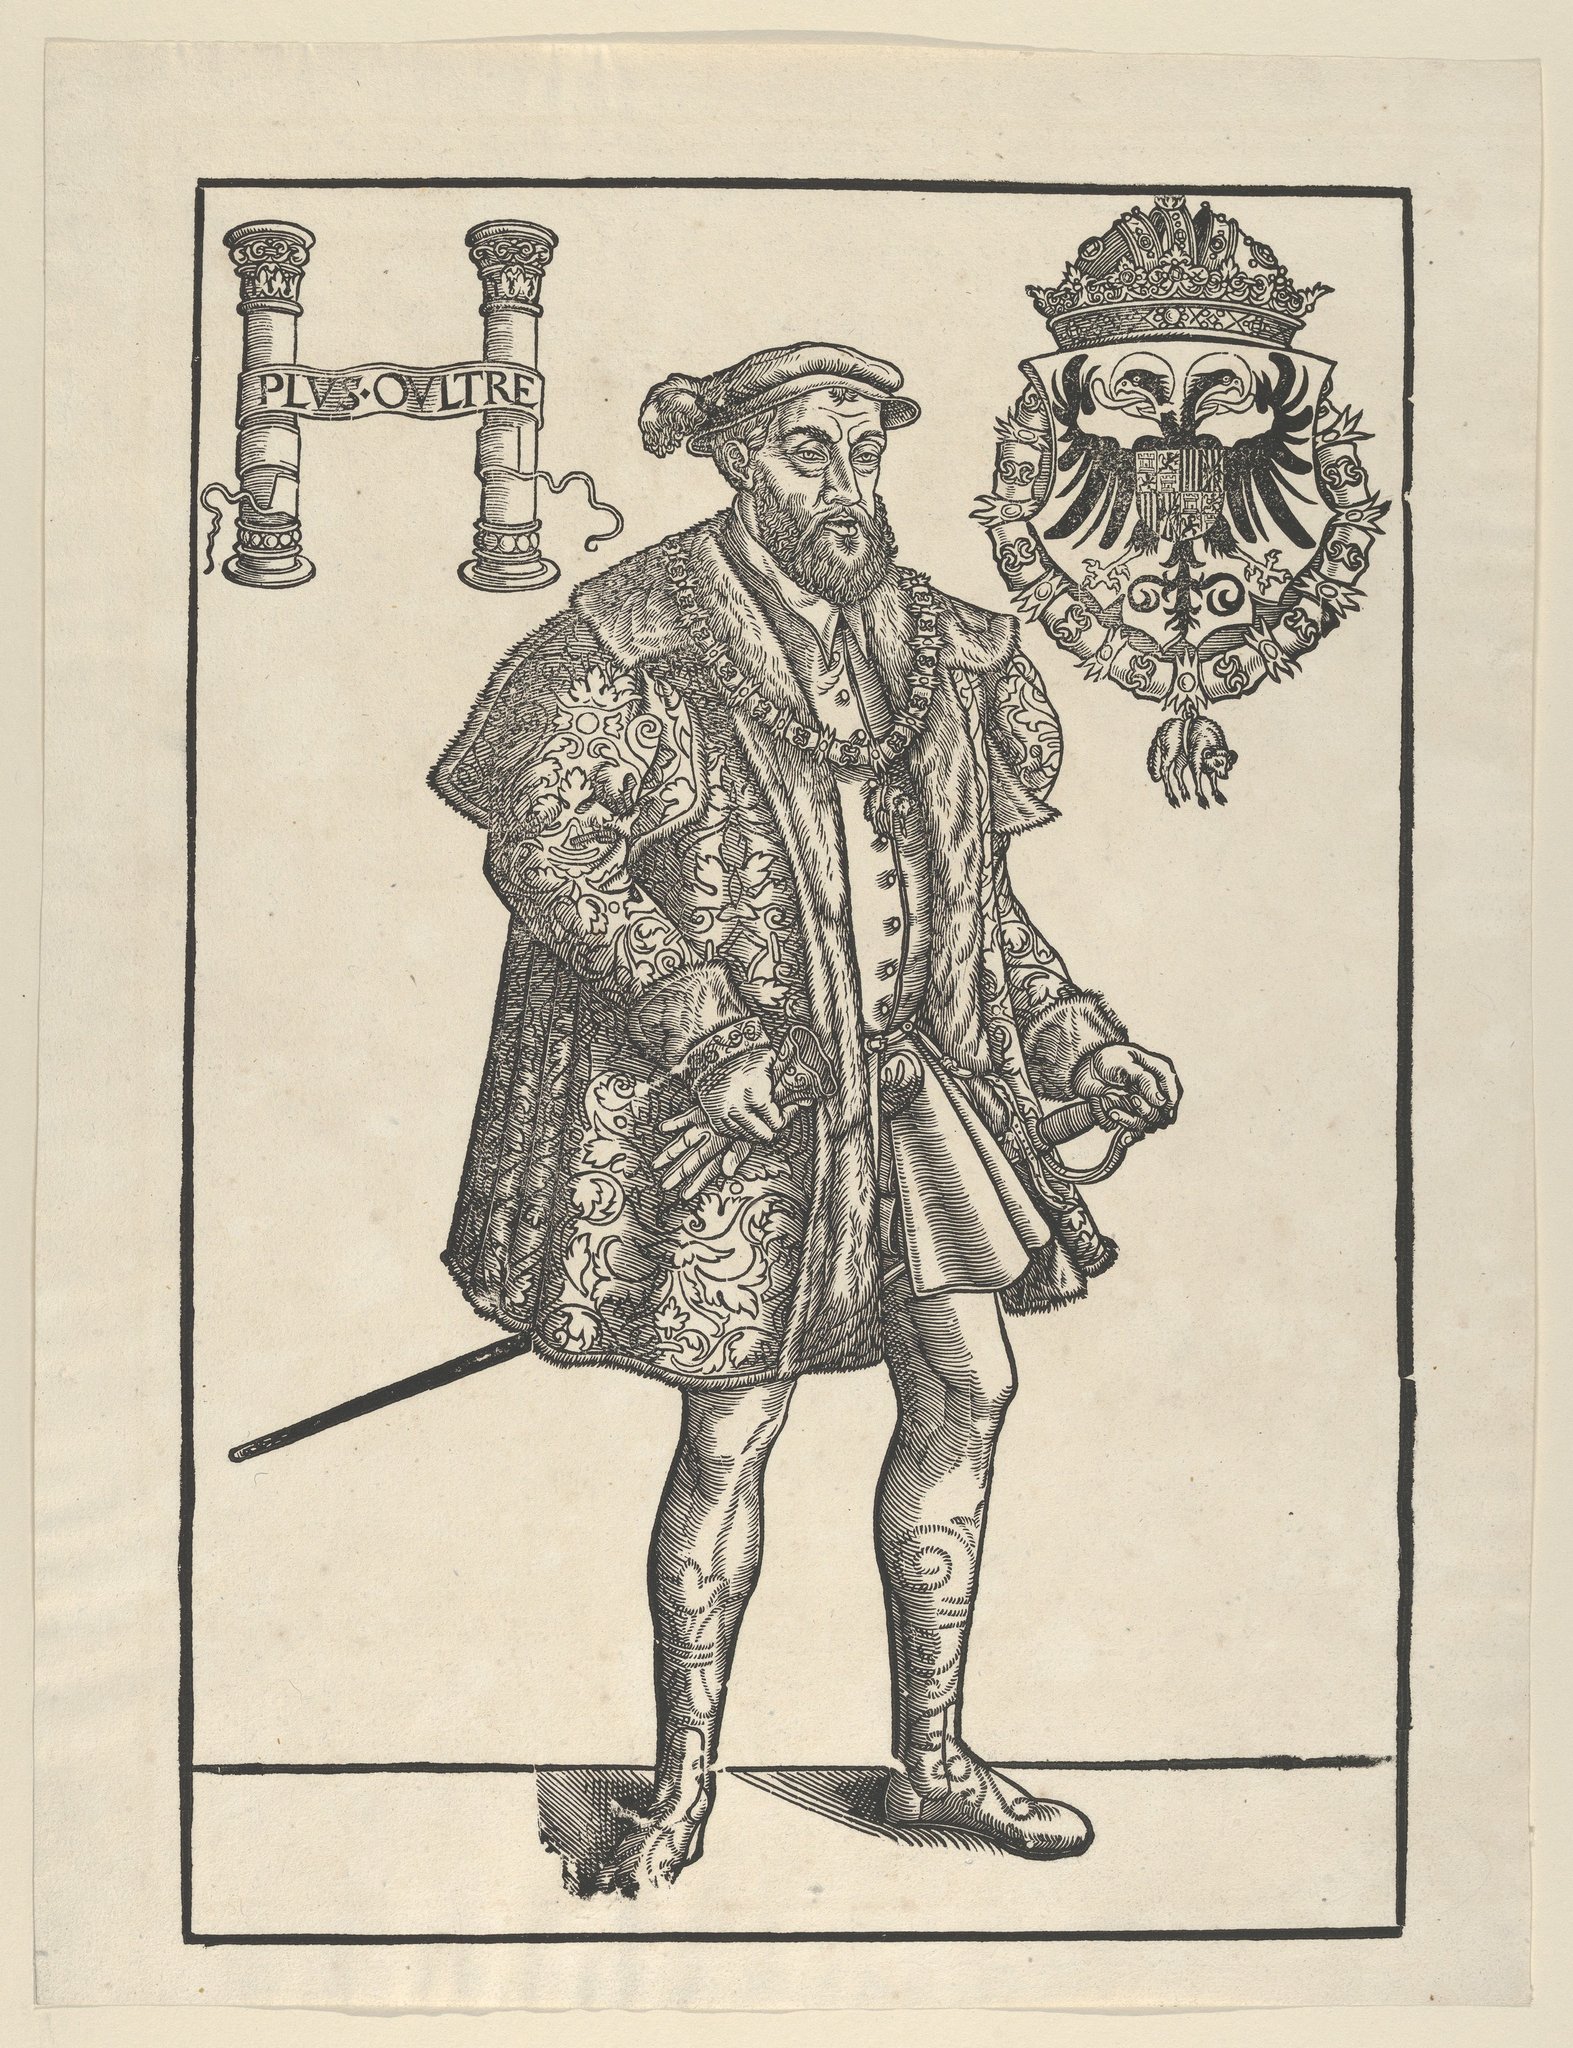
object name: print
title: Copy of Emperor Charles V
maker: lucas cranach the younger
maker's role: artist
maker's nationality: german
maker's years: 1515-1586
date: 1472-1553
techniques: woodcut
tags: swords,men